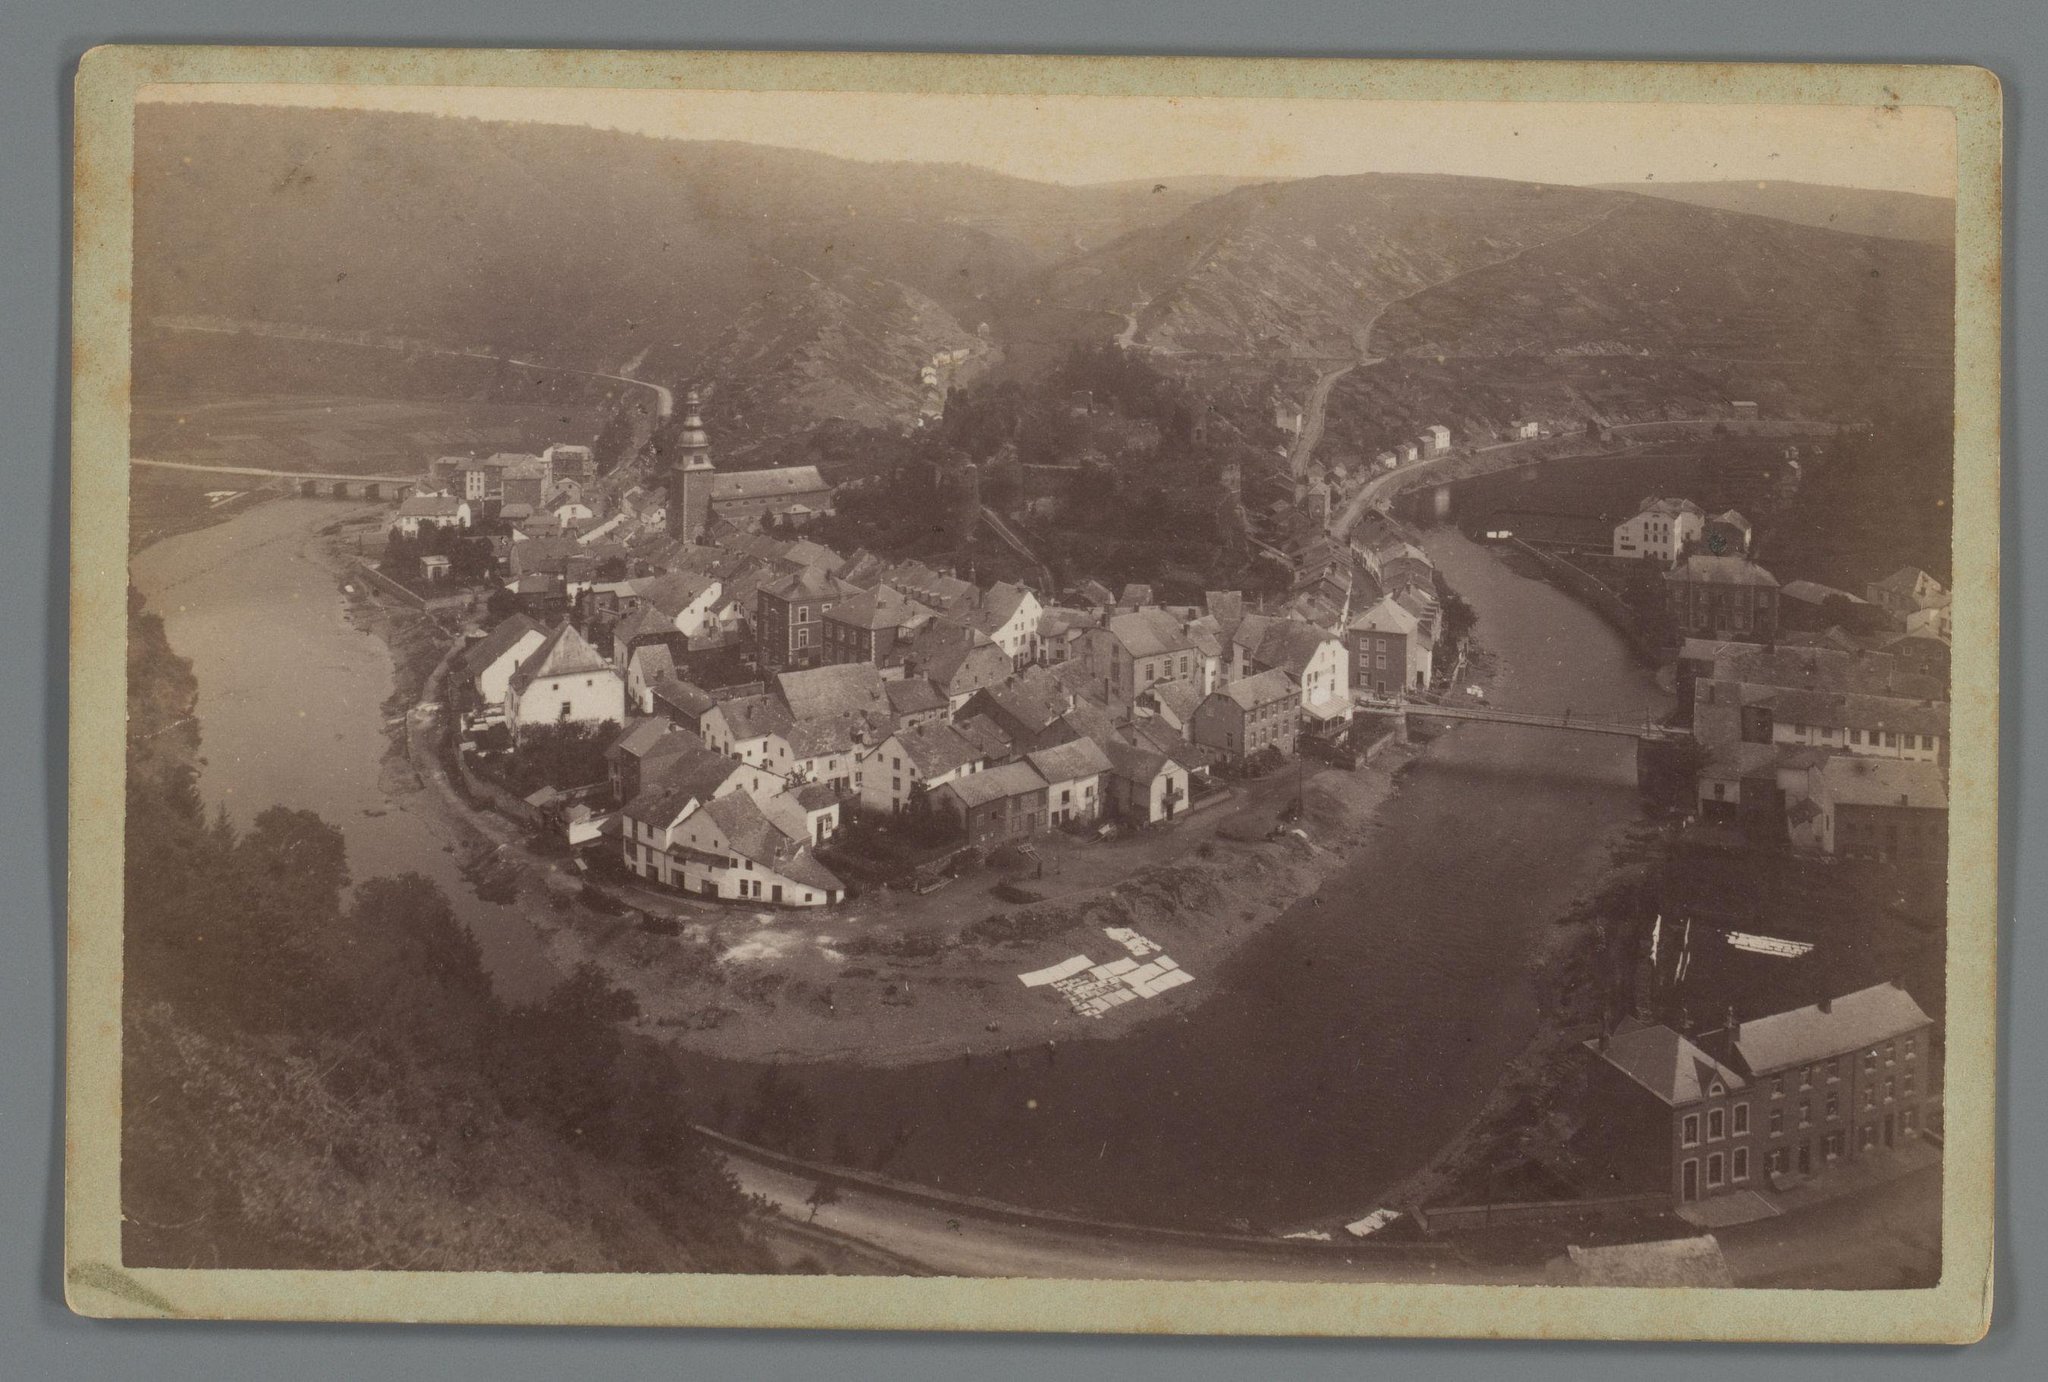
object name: cabinet photograph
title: Gezicht op La Roche-en-Ardenne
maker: otto taudien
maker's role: fotograaf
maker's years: 1857-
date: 1891-1892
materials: cardboard, paper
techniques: albumen print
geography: la roche-en-ardenne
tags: city-view in general; 'veduta', river, landscape with tower or castle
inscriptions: address: ‘TAUDIEN PHOT./ VERVIERS/ 190, Rue Tranchée, 190’